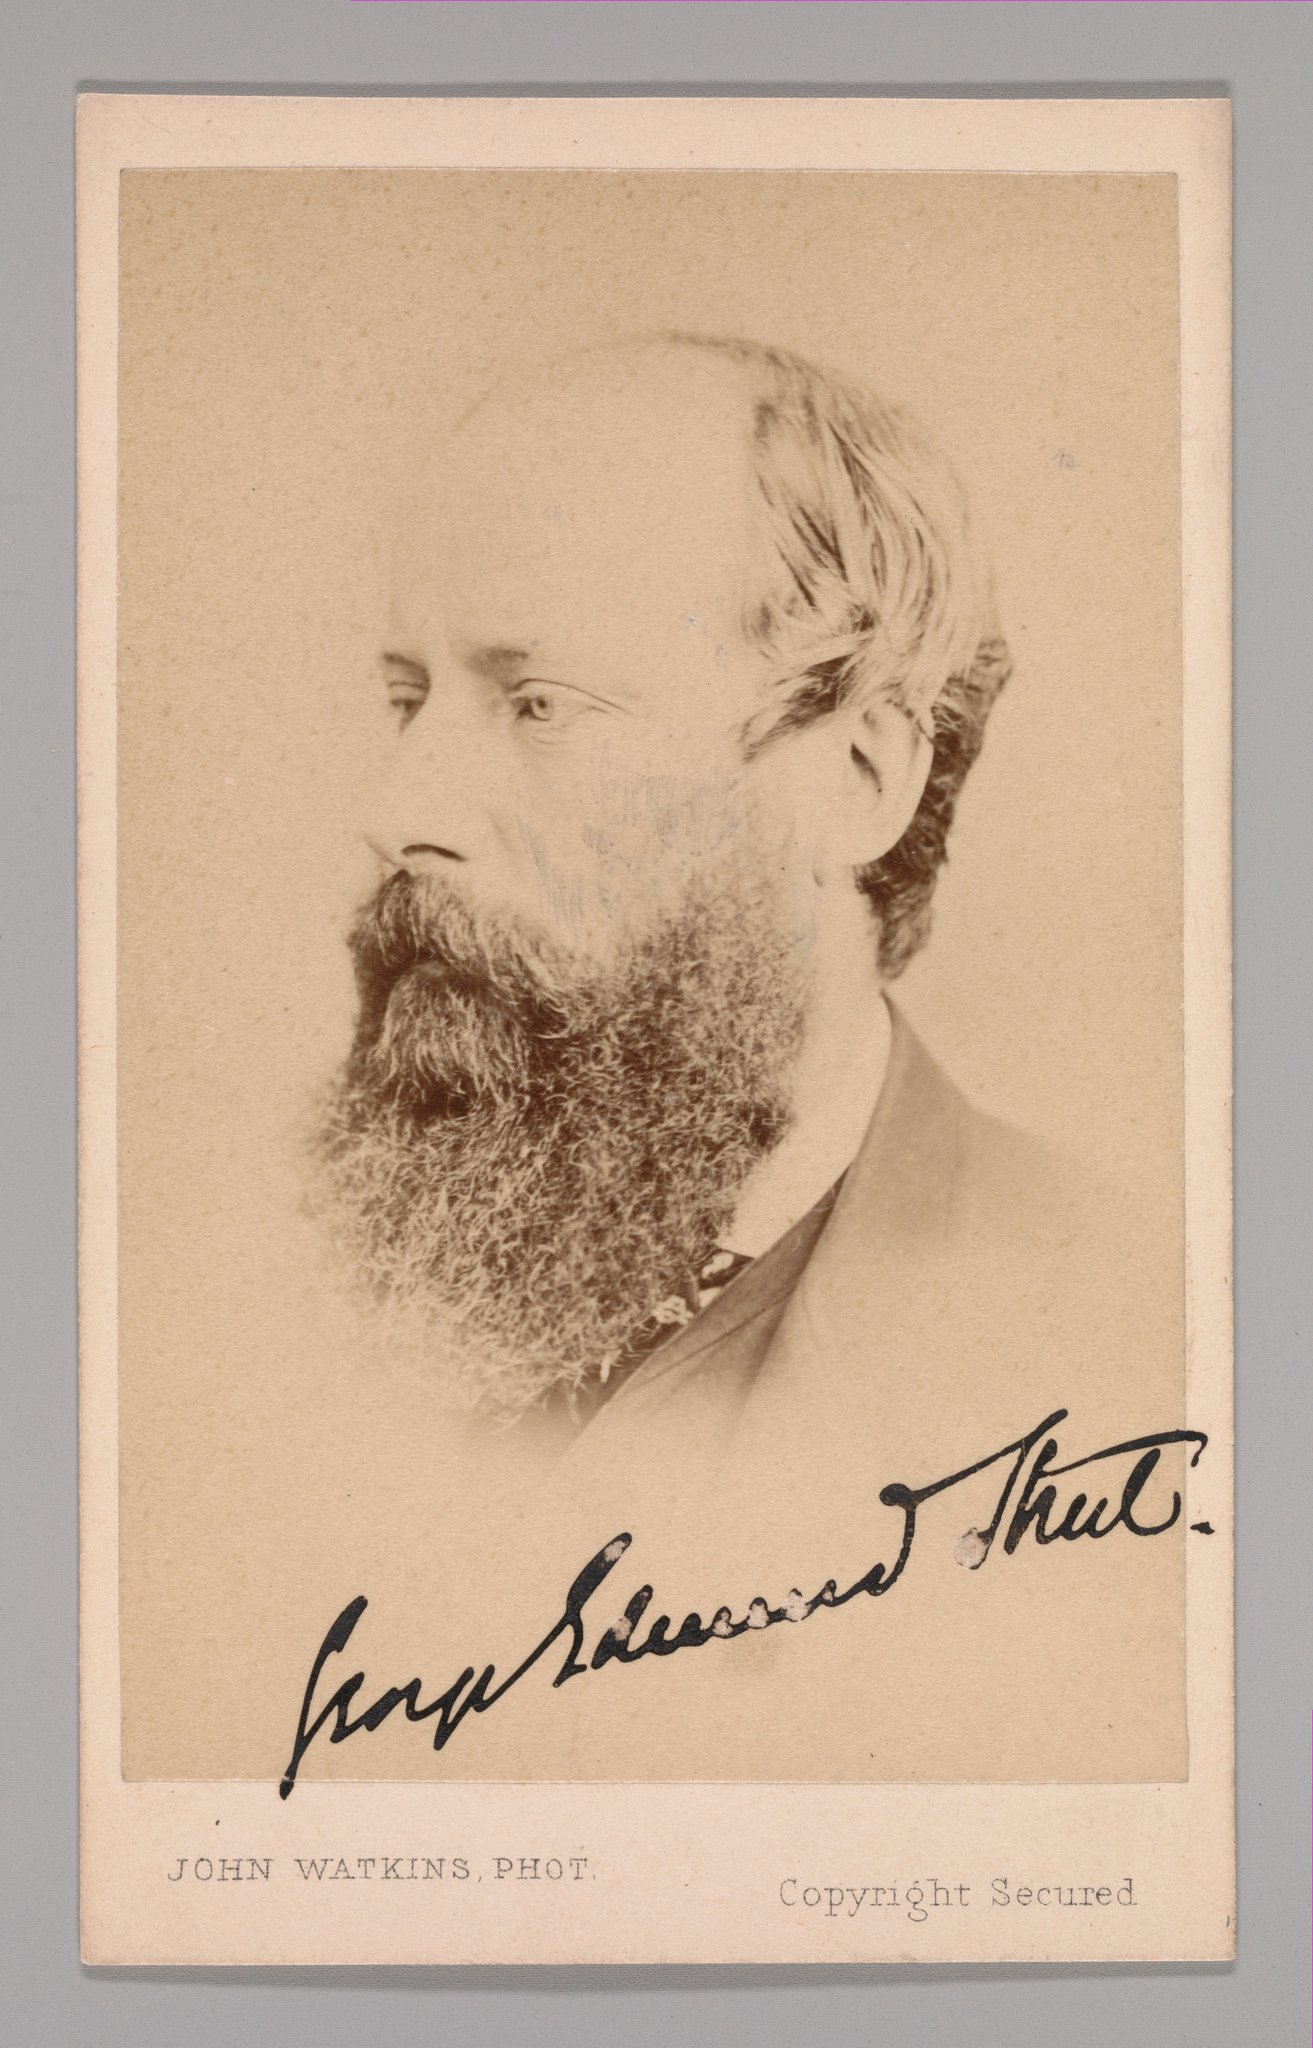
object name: carte de visite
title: [George Edward ?]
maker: john and charles watkins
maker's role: photography studio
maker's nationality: british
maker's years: 1840-1875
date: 1860-1869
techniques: albumen silver print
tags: men,portraits